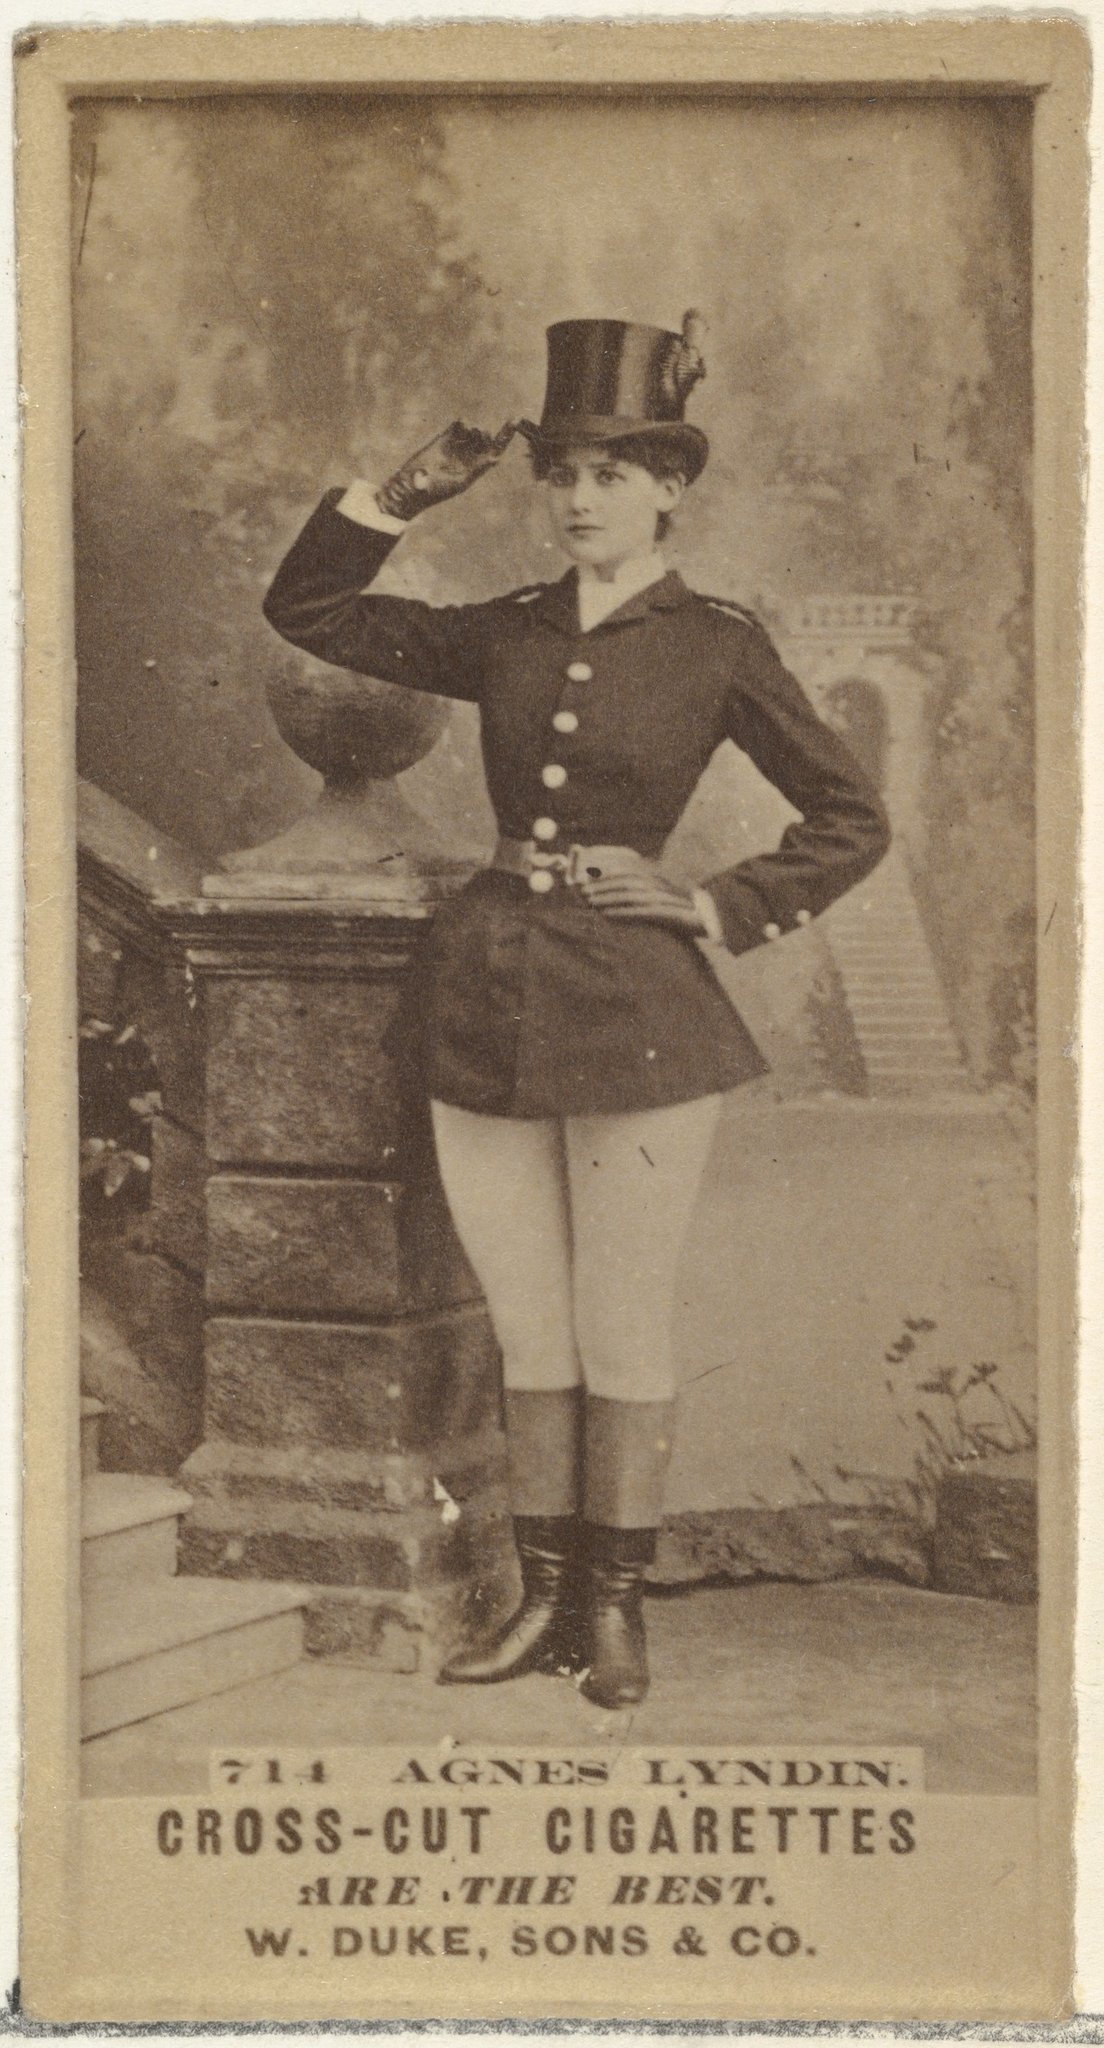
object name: photograph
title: Card Number 714, Agnes Lyndin, from the Actors and Actresses series (N145-3) issued by Duke Sons & Co. to promote Cross Cut Cigarettes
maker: w. duke, sons & co.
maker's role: publisher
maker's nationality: american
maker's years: 1870-1920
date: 1880-1889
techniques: albumen silver print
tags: portraits,women,actresses